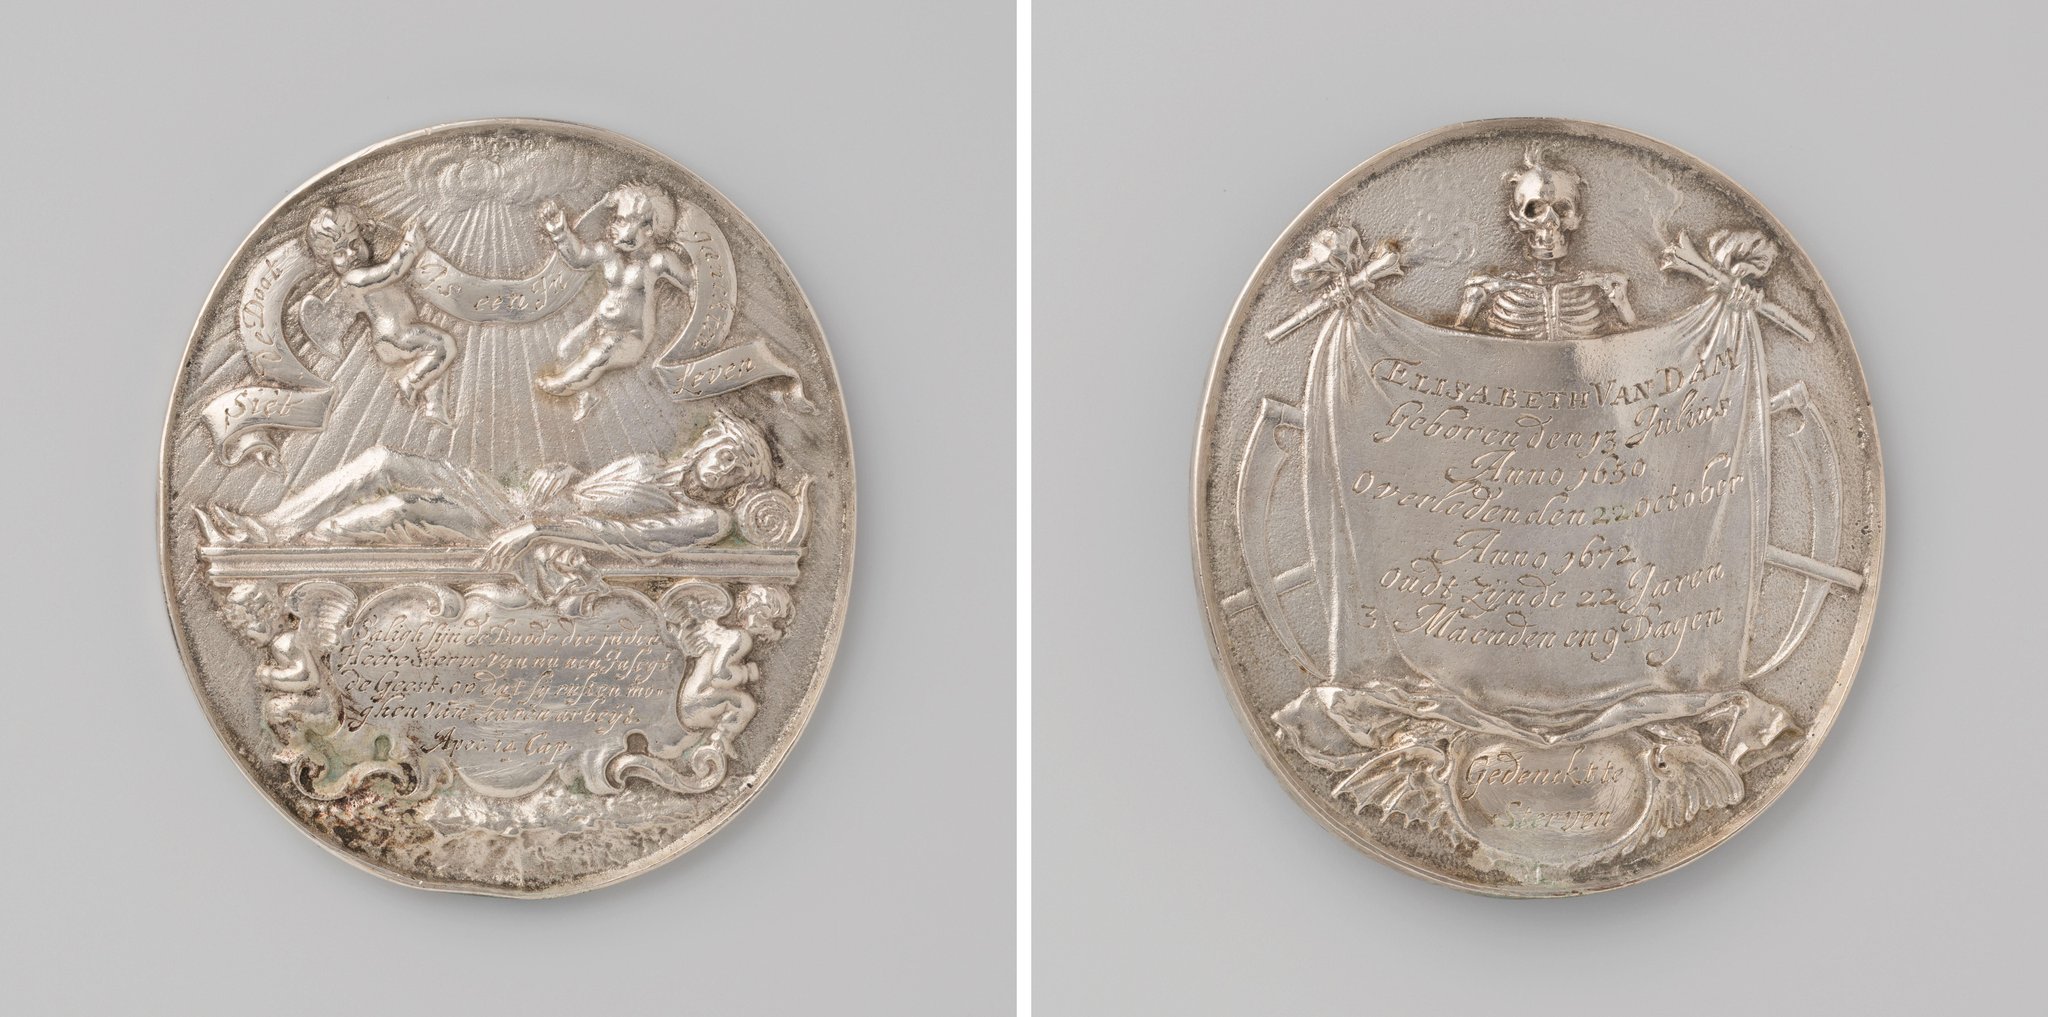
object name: overlijdenspenning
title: Death of Elisabeth van Dam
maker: wouter muller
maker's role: publisher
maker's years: 1604-1673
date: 1660-1672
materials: silver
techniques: casting, engraving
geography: amsterdam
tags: elisabeth van dam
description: In the past, important events were graced with a medal, especially in well-to-do families. The occasion for this was usually a birth, wedding, or death. These medals not only remained in the family as a memento, but were also given to the guests at the baptism, wedding party, or funeral. Sometimes they were purely private in character, such as the gold medal a grandfather gave to his grandson.